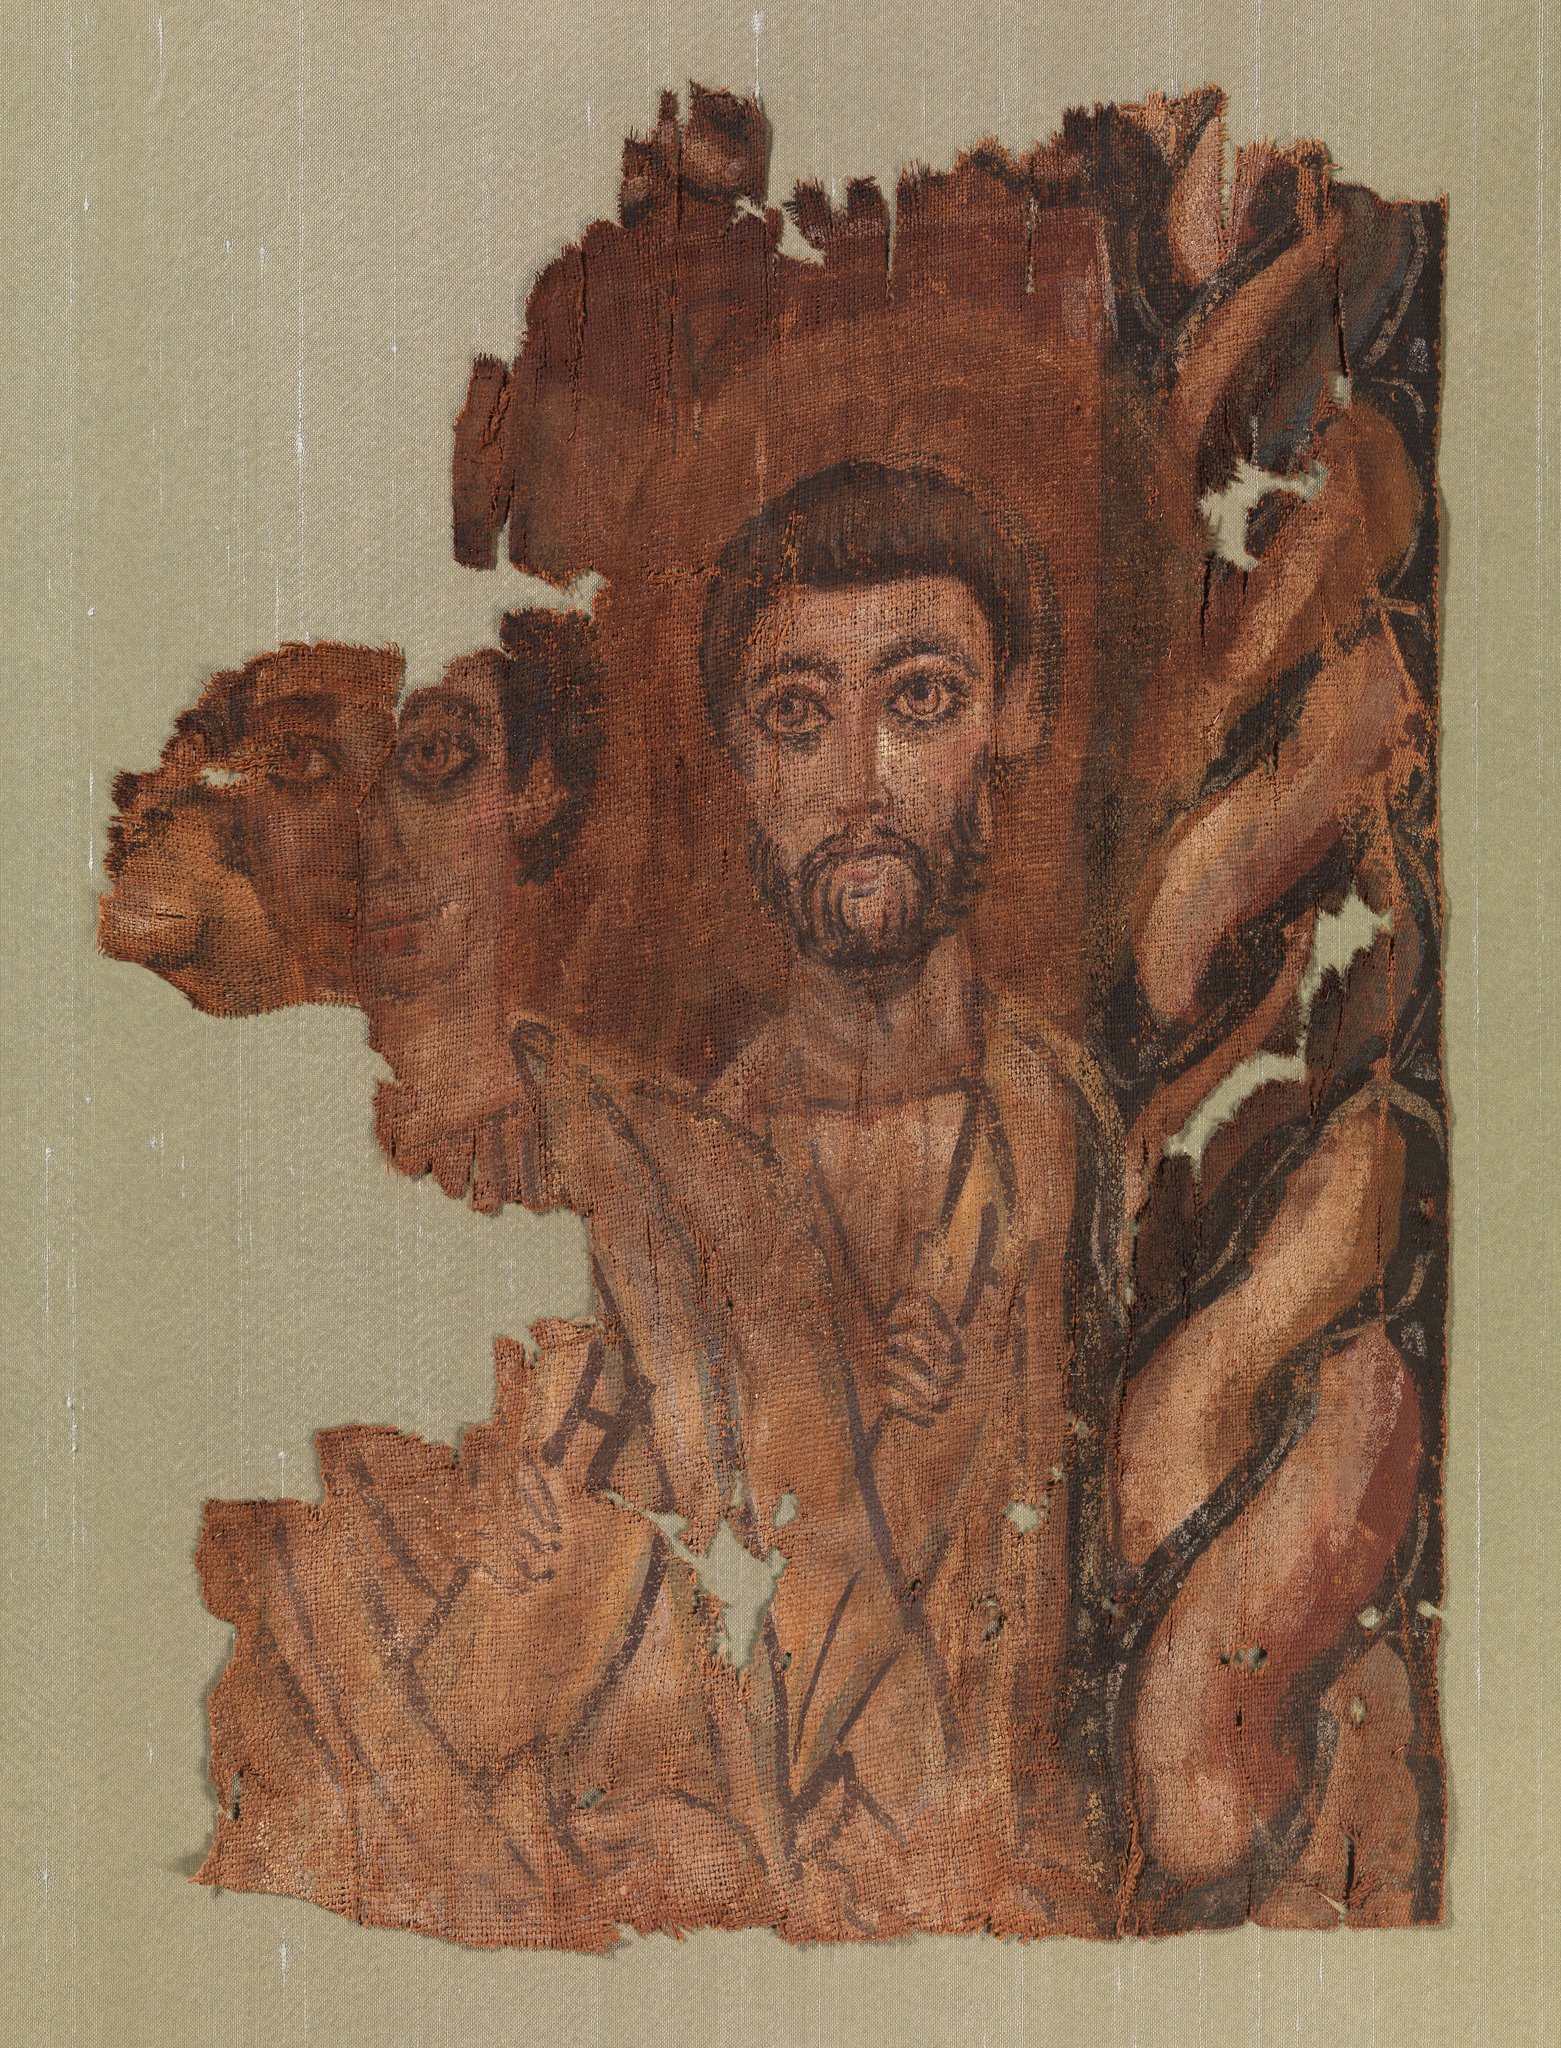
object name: painting of holy men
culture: byzantine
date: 401-600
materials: linen, paint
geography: egypt